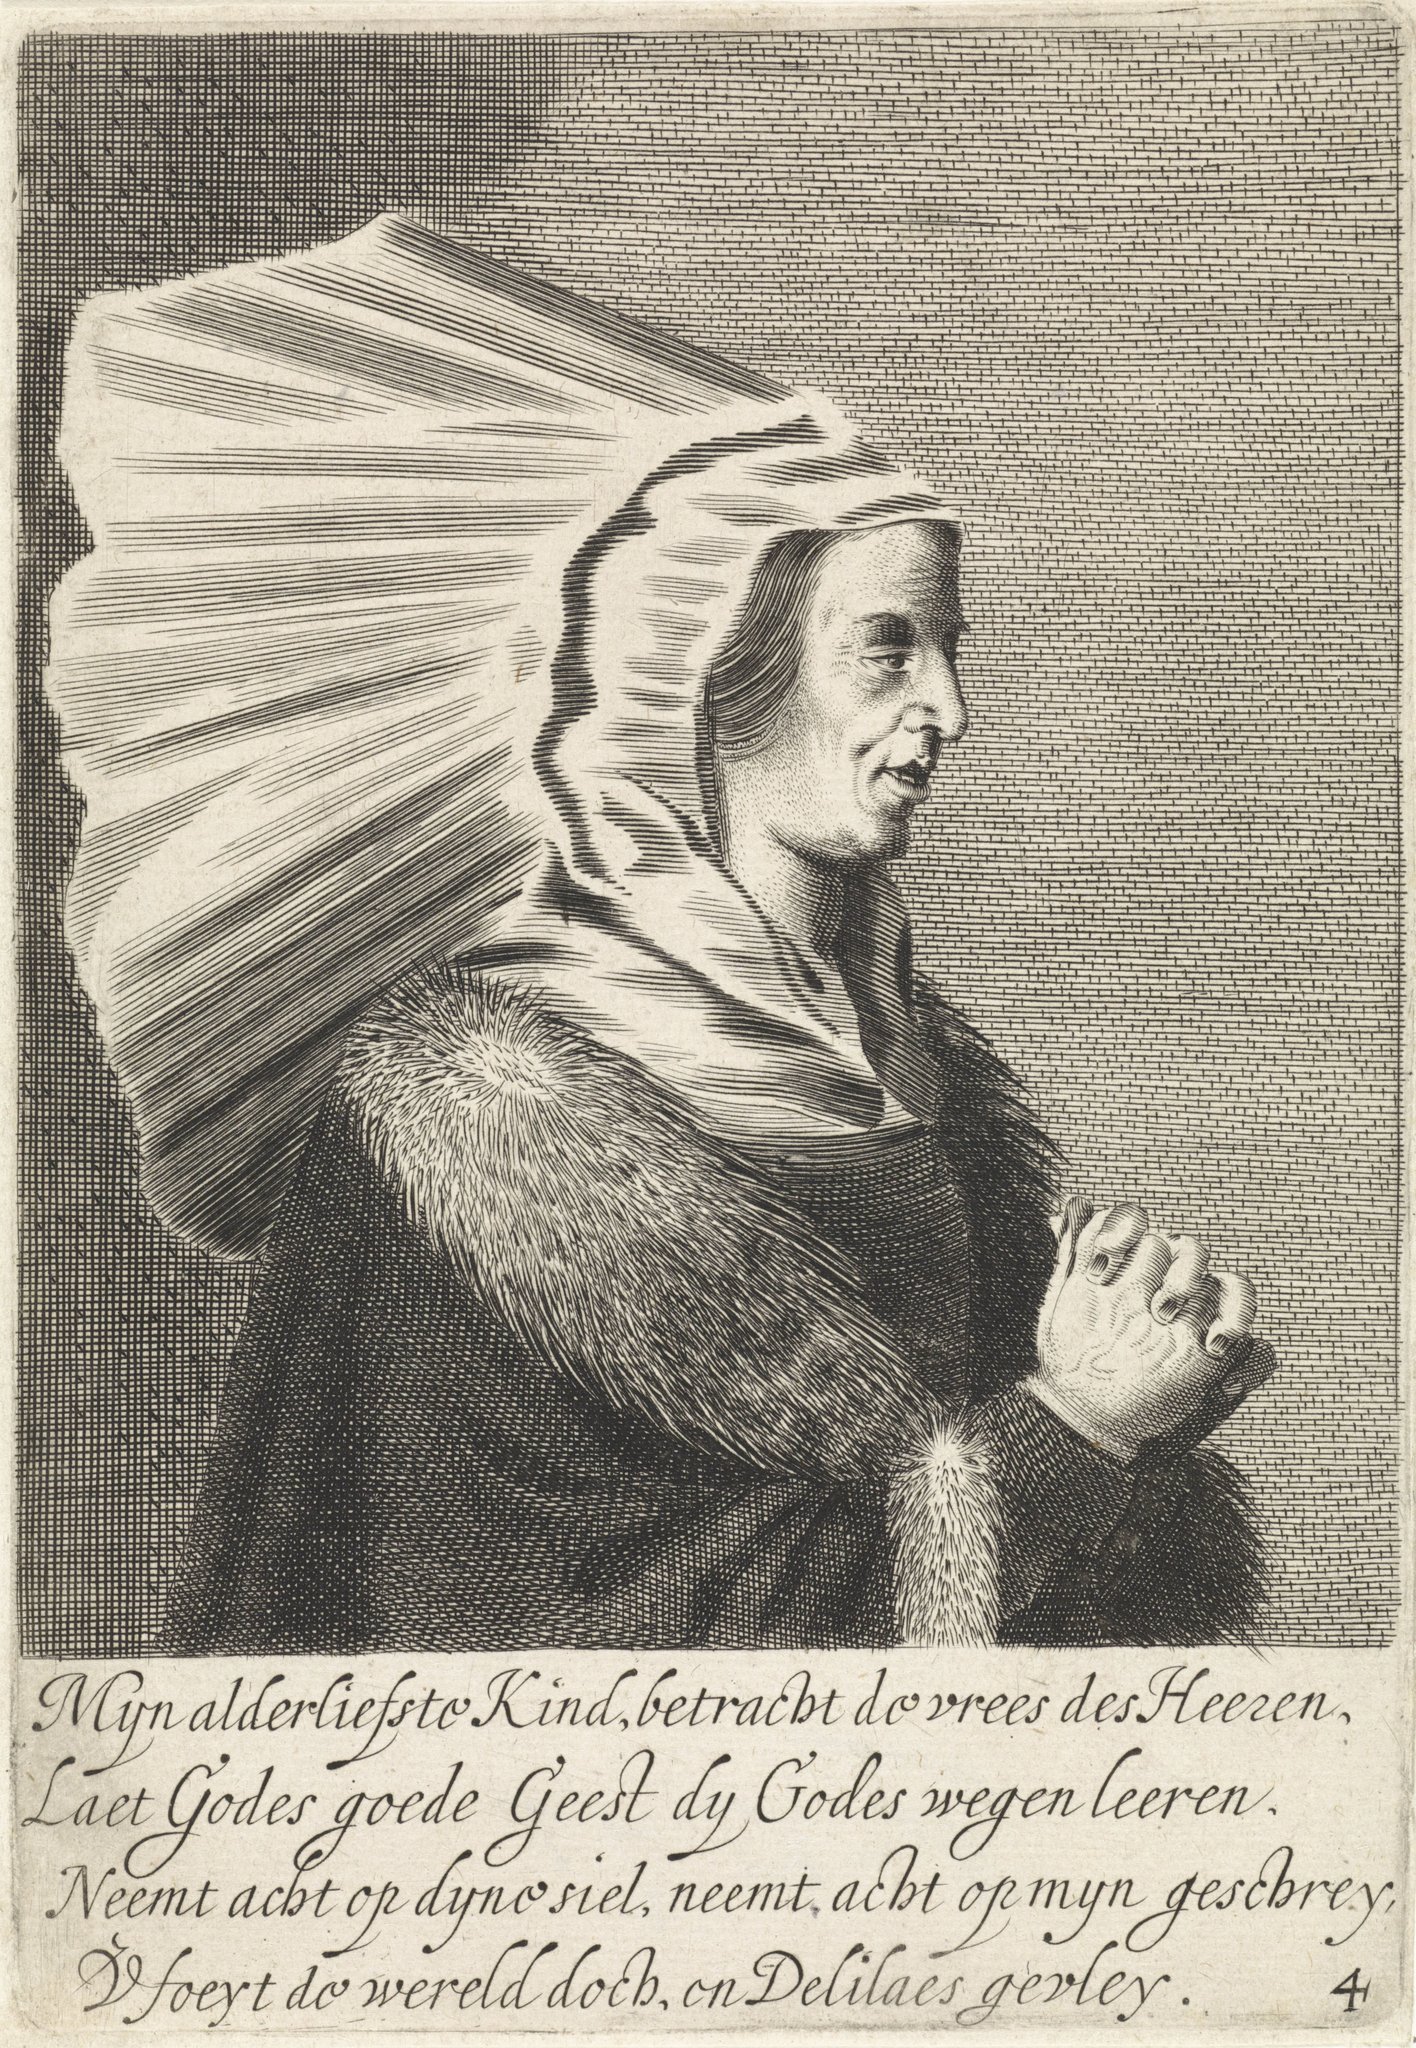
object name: print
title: Spigel, ofte Toneel der ydelheyd ende ongebondenheyd onser eeuwe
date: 1633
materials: paper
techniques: engraving, etching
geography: amsterdam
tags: hands folded with fingers knit, old woman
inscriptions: collector's mark: Lugt 240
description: Een moeder met een enorme kap op haar hoofd, spreekt haar kind toe, op te passen voor de verlokkingen van het leven. Vierde prent uit een serie van achttien.